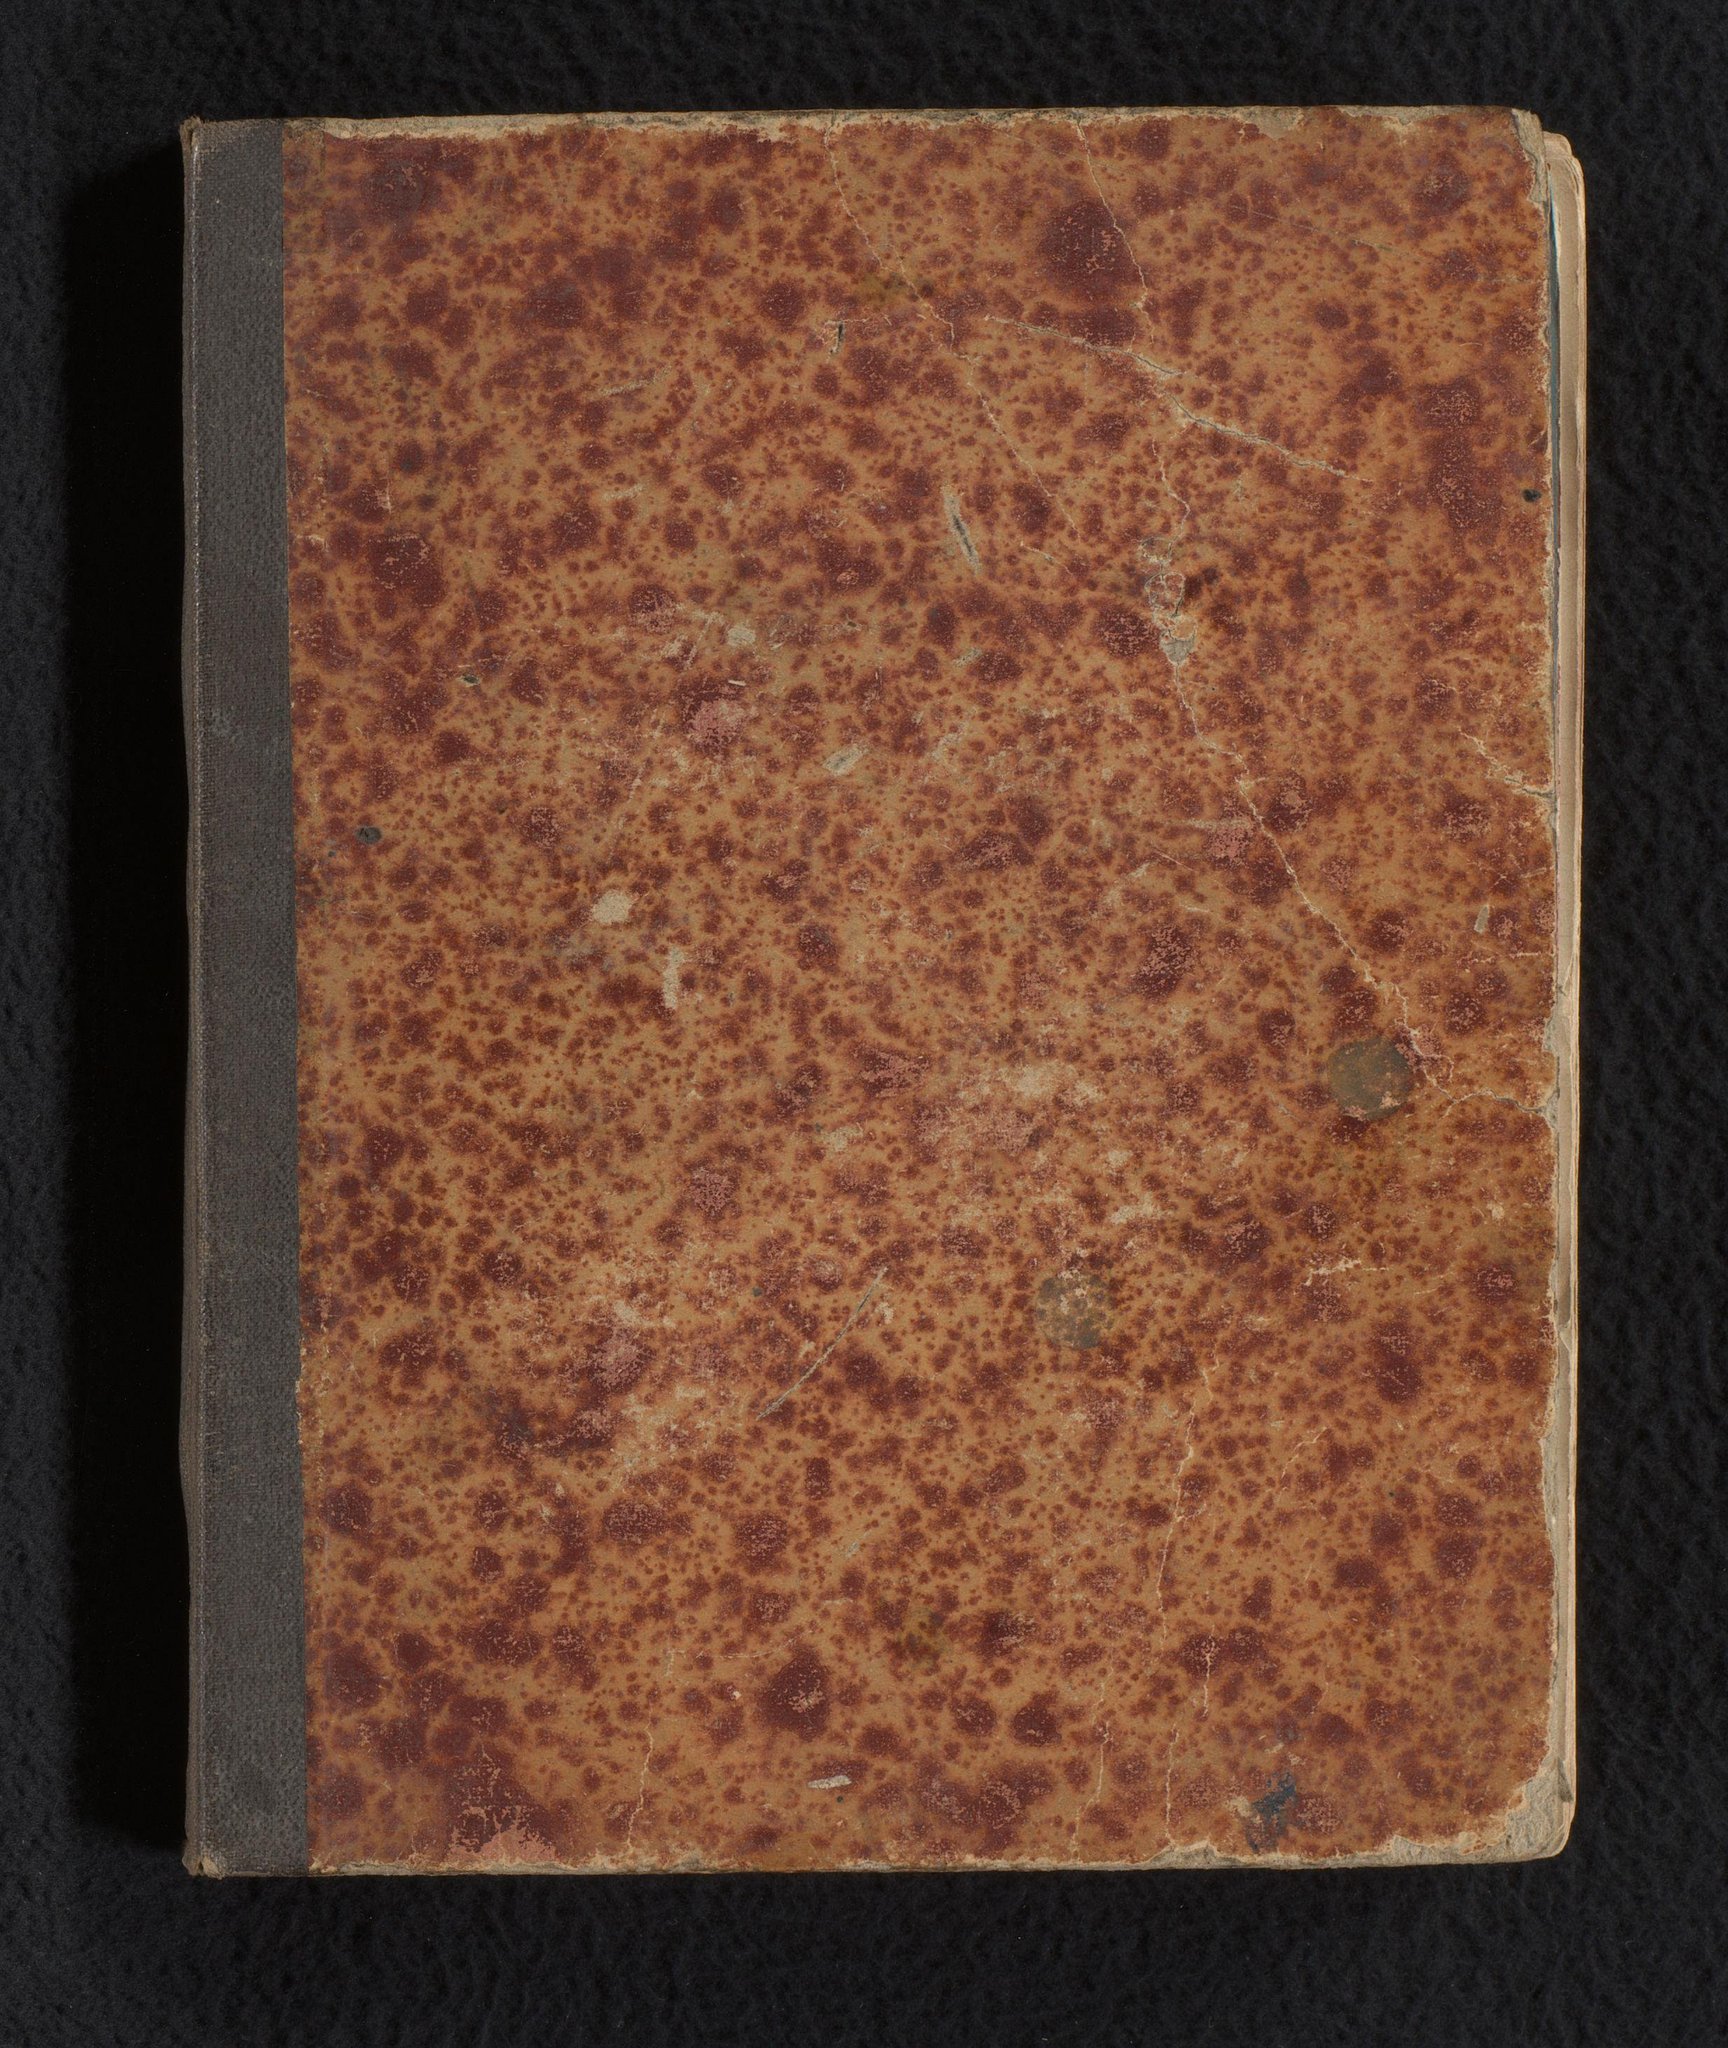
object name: scrapbook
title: Notebook with 108 Photographs of Models Owned by Jacques de Lalaing (1858-1917)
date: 1883-1914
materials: cardboard, paper, photographic support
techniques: marbled paper, albumen print, drawing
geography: brussels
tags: adult woman, the (nude) human figure; 'corpo humano' (ripa), adult man, child, historical persons, infant, baby, artist (in general) working from nude model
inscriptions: annotation: ‘No. 6’, label: ‘E.M.Heger Cantersteen 29 Bruxelles’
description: Scores of 19th-century artists owned photographs. The Brussels sculptor Jacques de Lalaing pasted them in a plain notebook he had bought at an office stationer’s. A small number of the photographs were taken by Marconi, Bonnard and Igout, well-known purveyors of ‘model photographs’ for artists. It is unclear whether Lalaing himself took the remaining photographs; however, they were definitely made in his studio as study material.